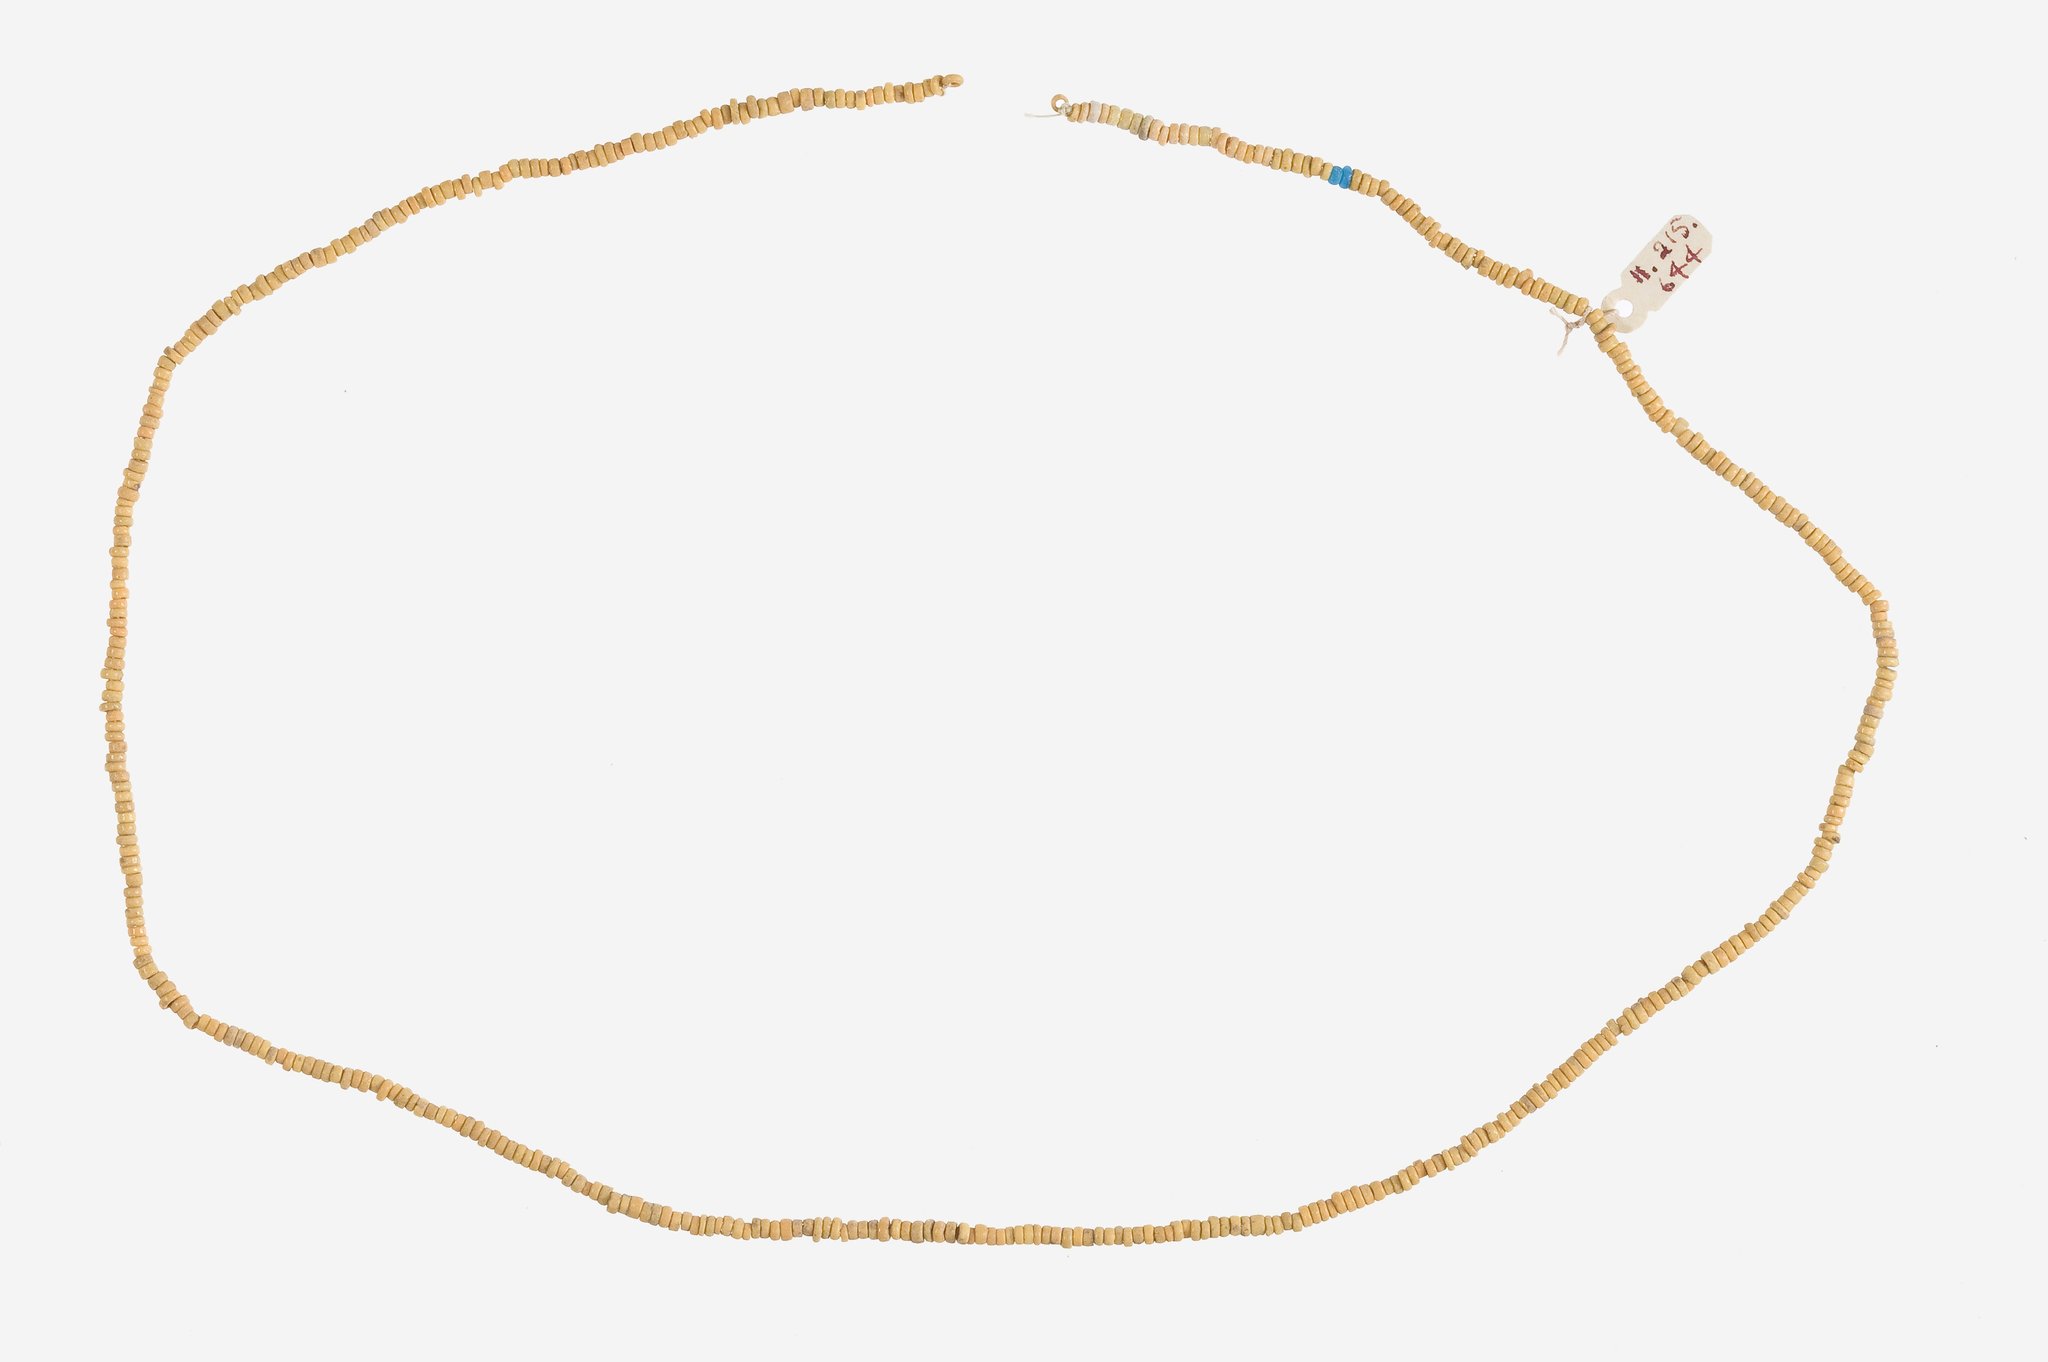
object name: bead, disk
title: String of Tiny Disk Beads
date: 1390-1352 BCE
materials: faience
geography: egypt